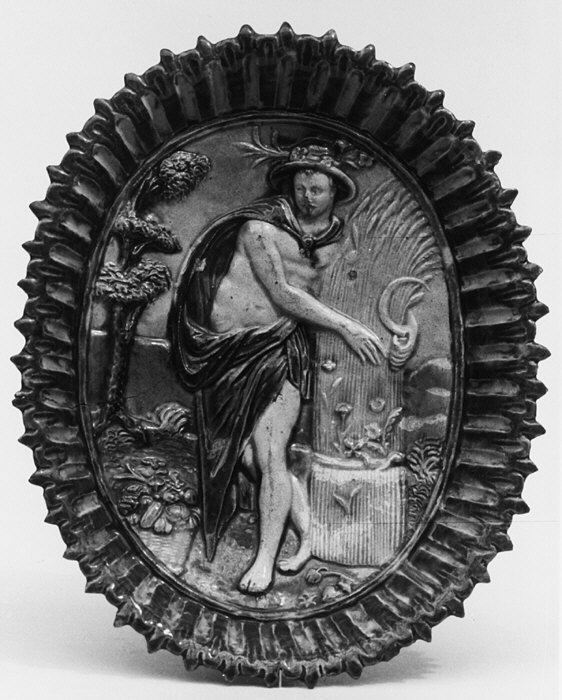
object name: dish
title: Dish with Allegory of Summer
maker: bernard palissy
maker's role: maker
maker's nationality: french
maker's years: 1510-1590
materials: earthenware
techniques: glazing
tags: men